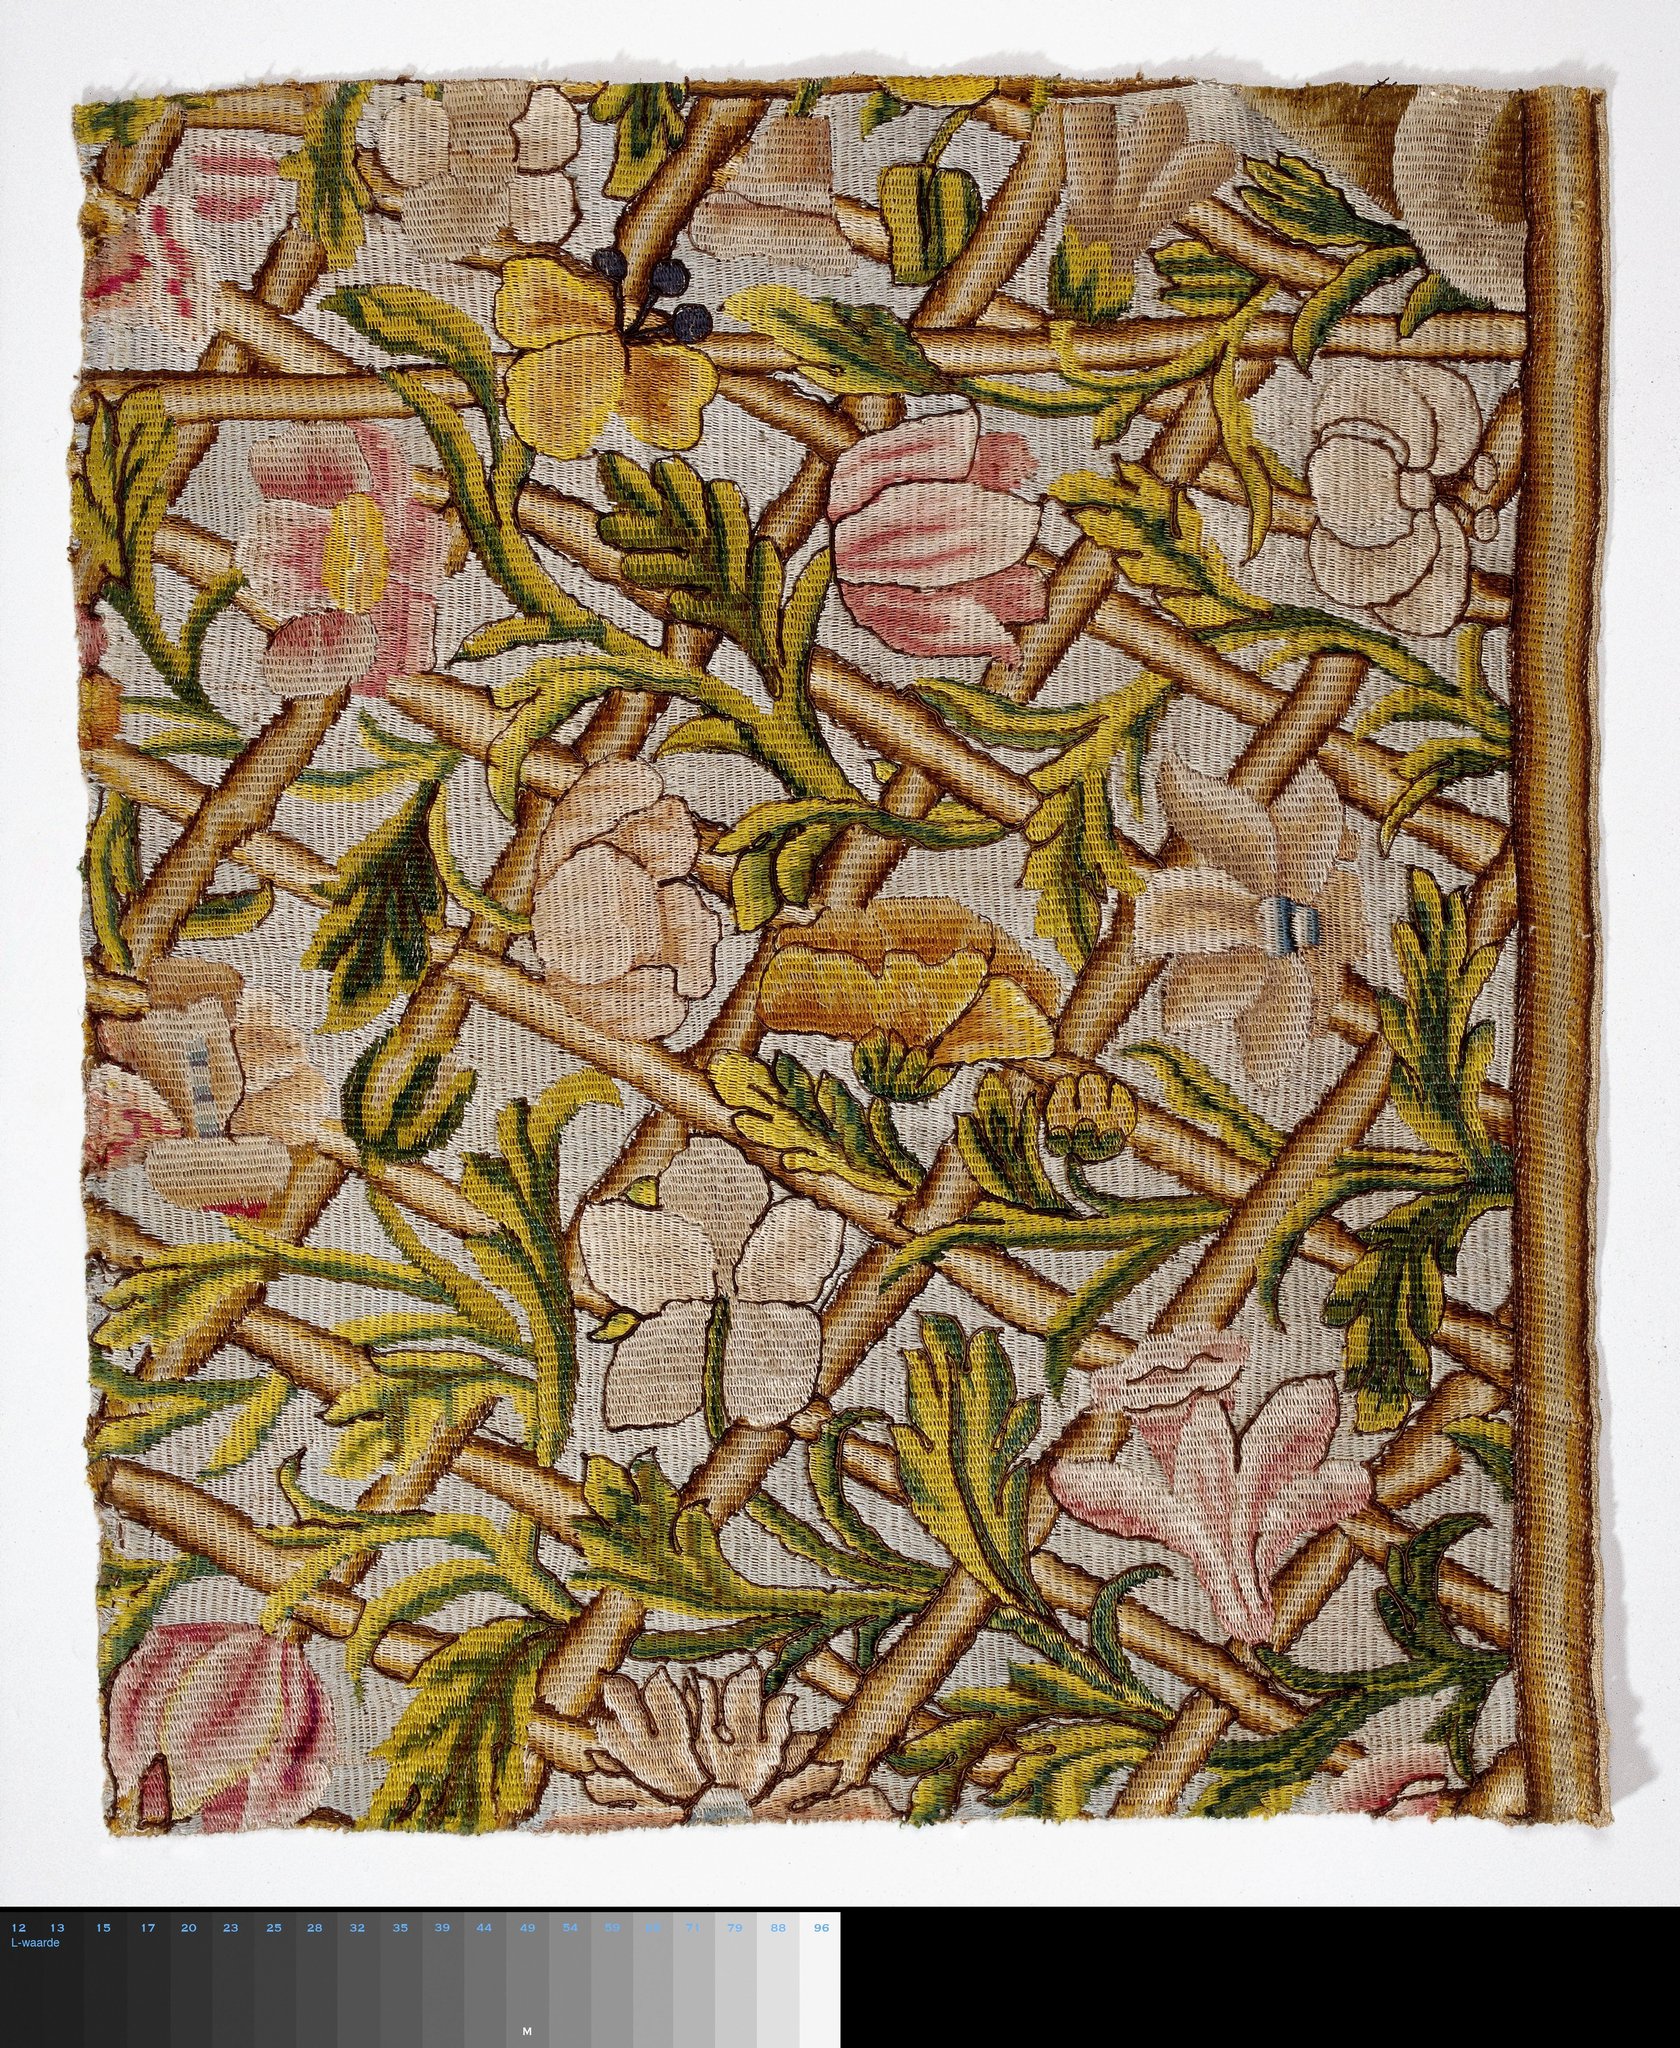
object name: embroidery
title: Fragment borduurwerk versierd met bloemen en takken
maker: trellis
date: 1860-1880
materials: wool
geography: england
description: Fragment borduursel. Op een stramien zijn met grote steken gewerkt stammen, die zich in ruitvormen kruisen en grote, rose, gele en grijze bloemen en takken, met groene bladeren op een blauwgrijze grond. Imitatie-behangsel.